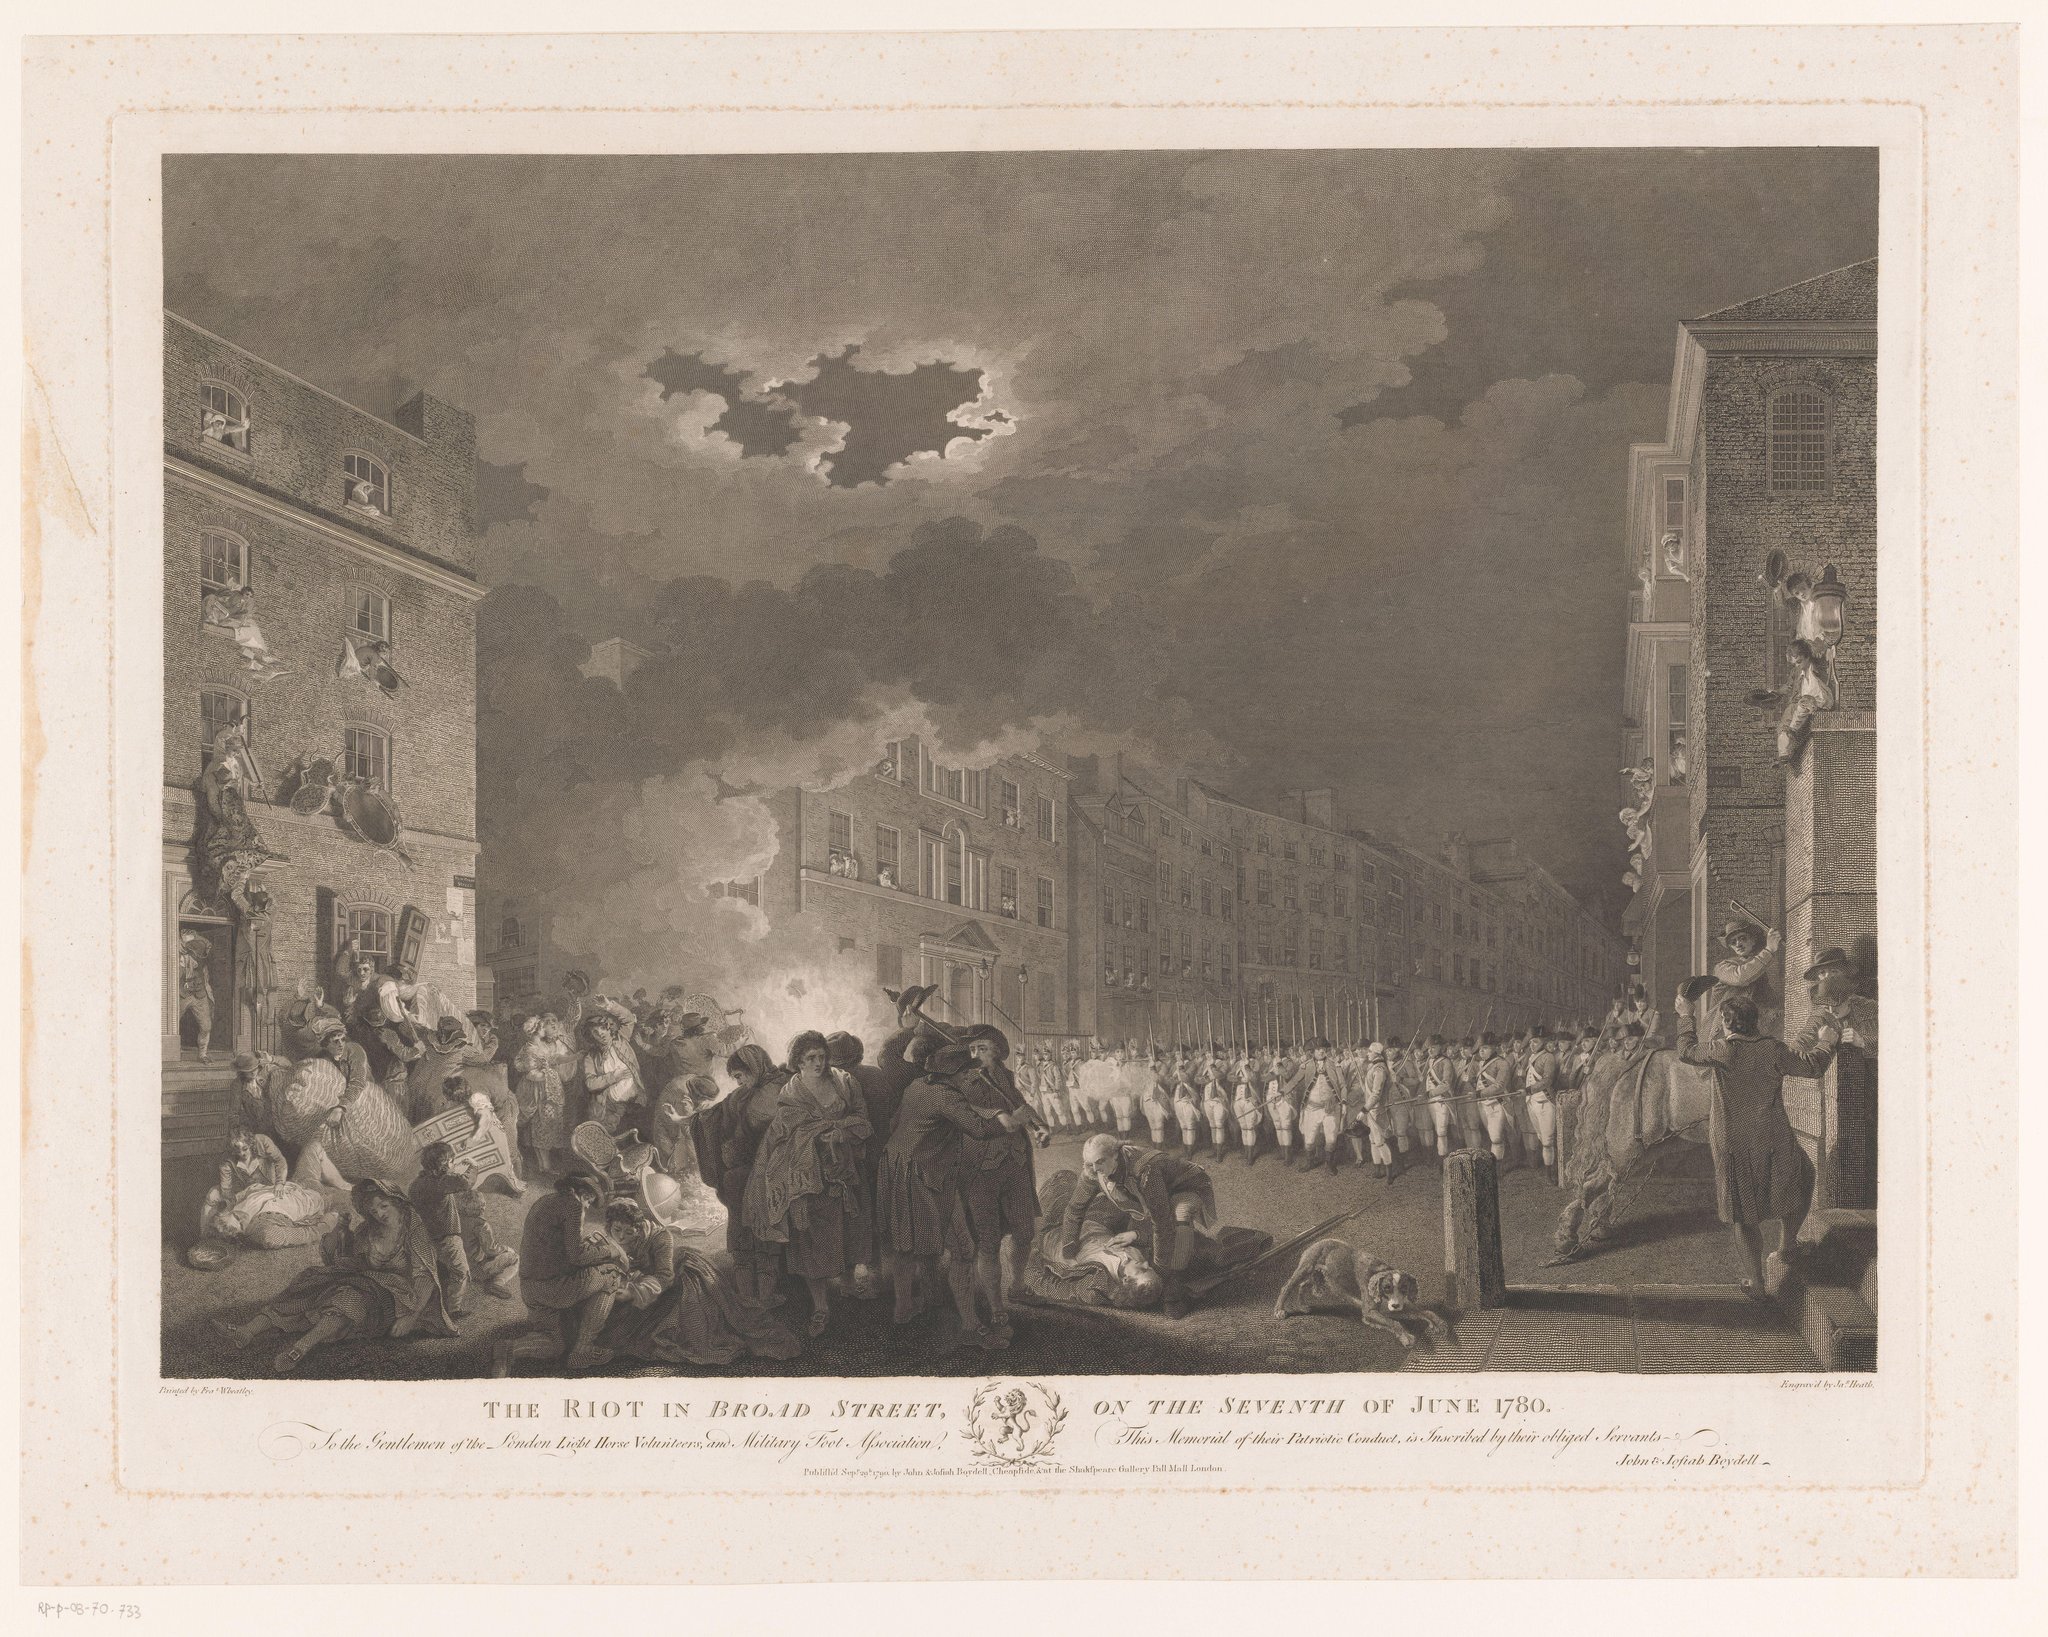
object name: print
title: The Riot in Broad Street on the seventh of June 1780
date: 1790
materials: paper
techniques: engraving, etching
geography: london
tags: barricades ~ riot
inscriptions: collector's mark: Lugt 12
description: Mensen gooien huisraad van een Ier genaamd Donovan naar buiten terwijl het leger klaar staat verderop in de straat.